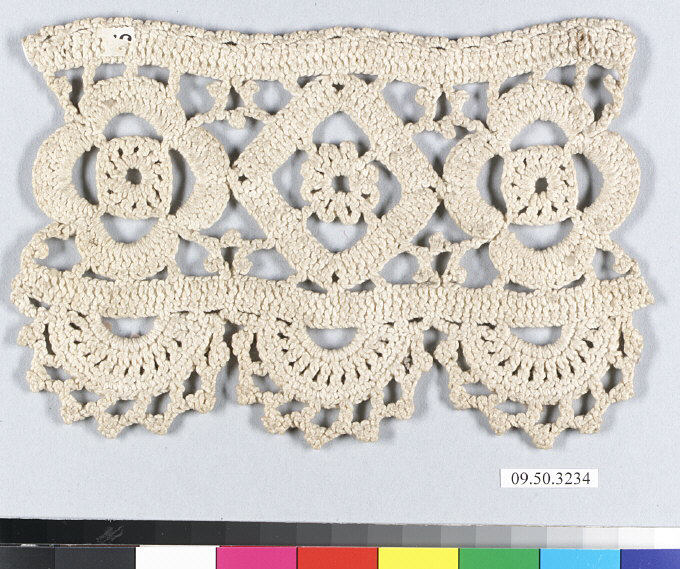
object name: sample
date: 1801-1900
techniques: crochet